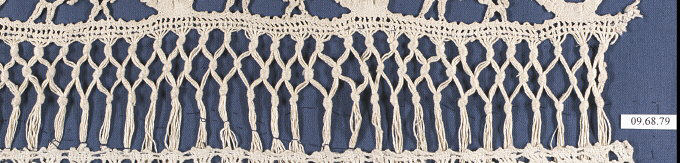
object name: border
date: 1600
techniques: lace